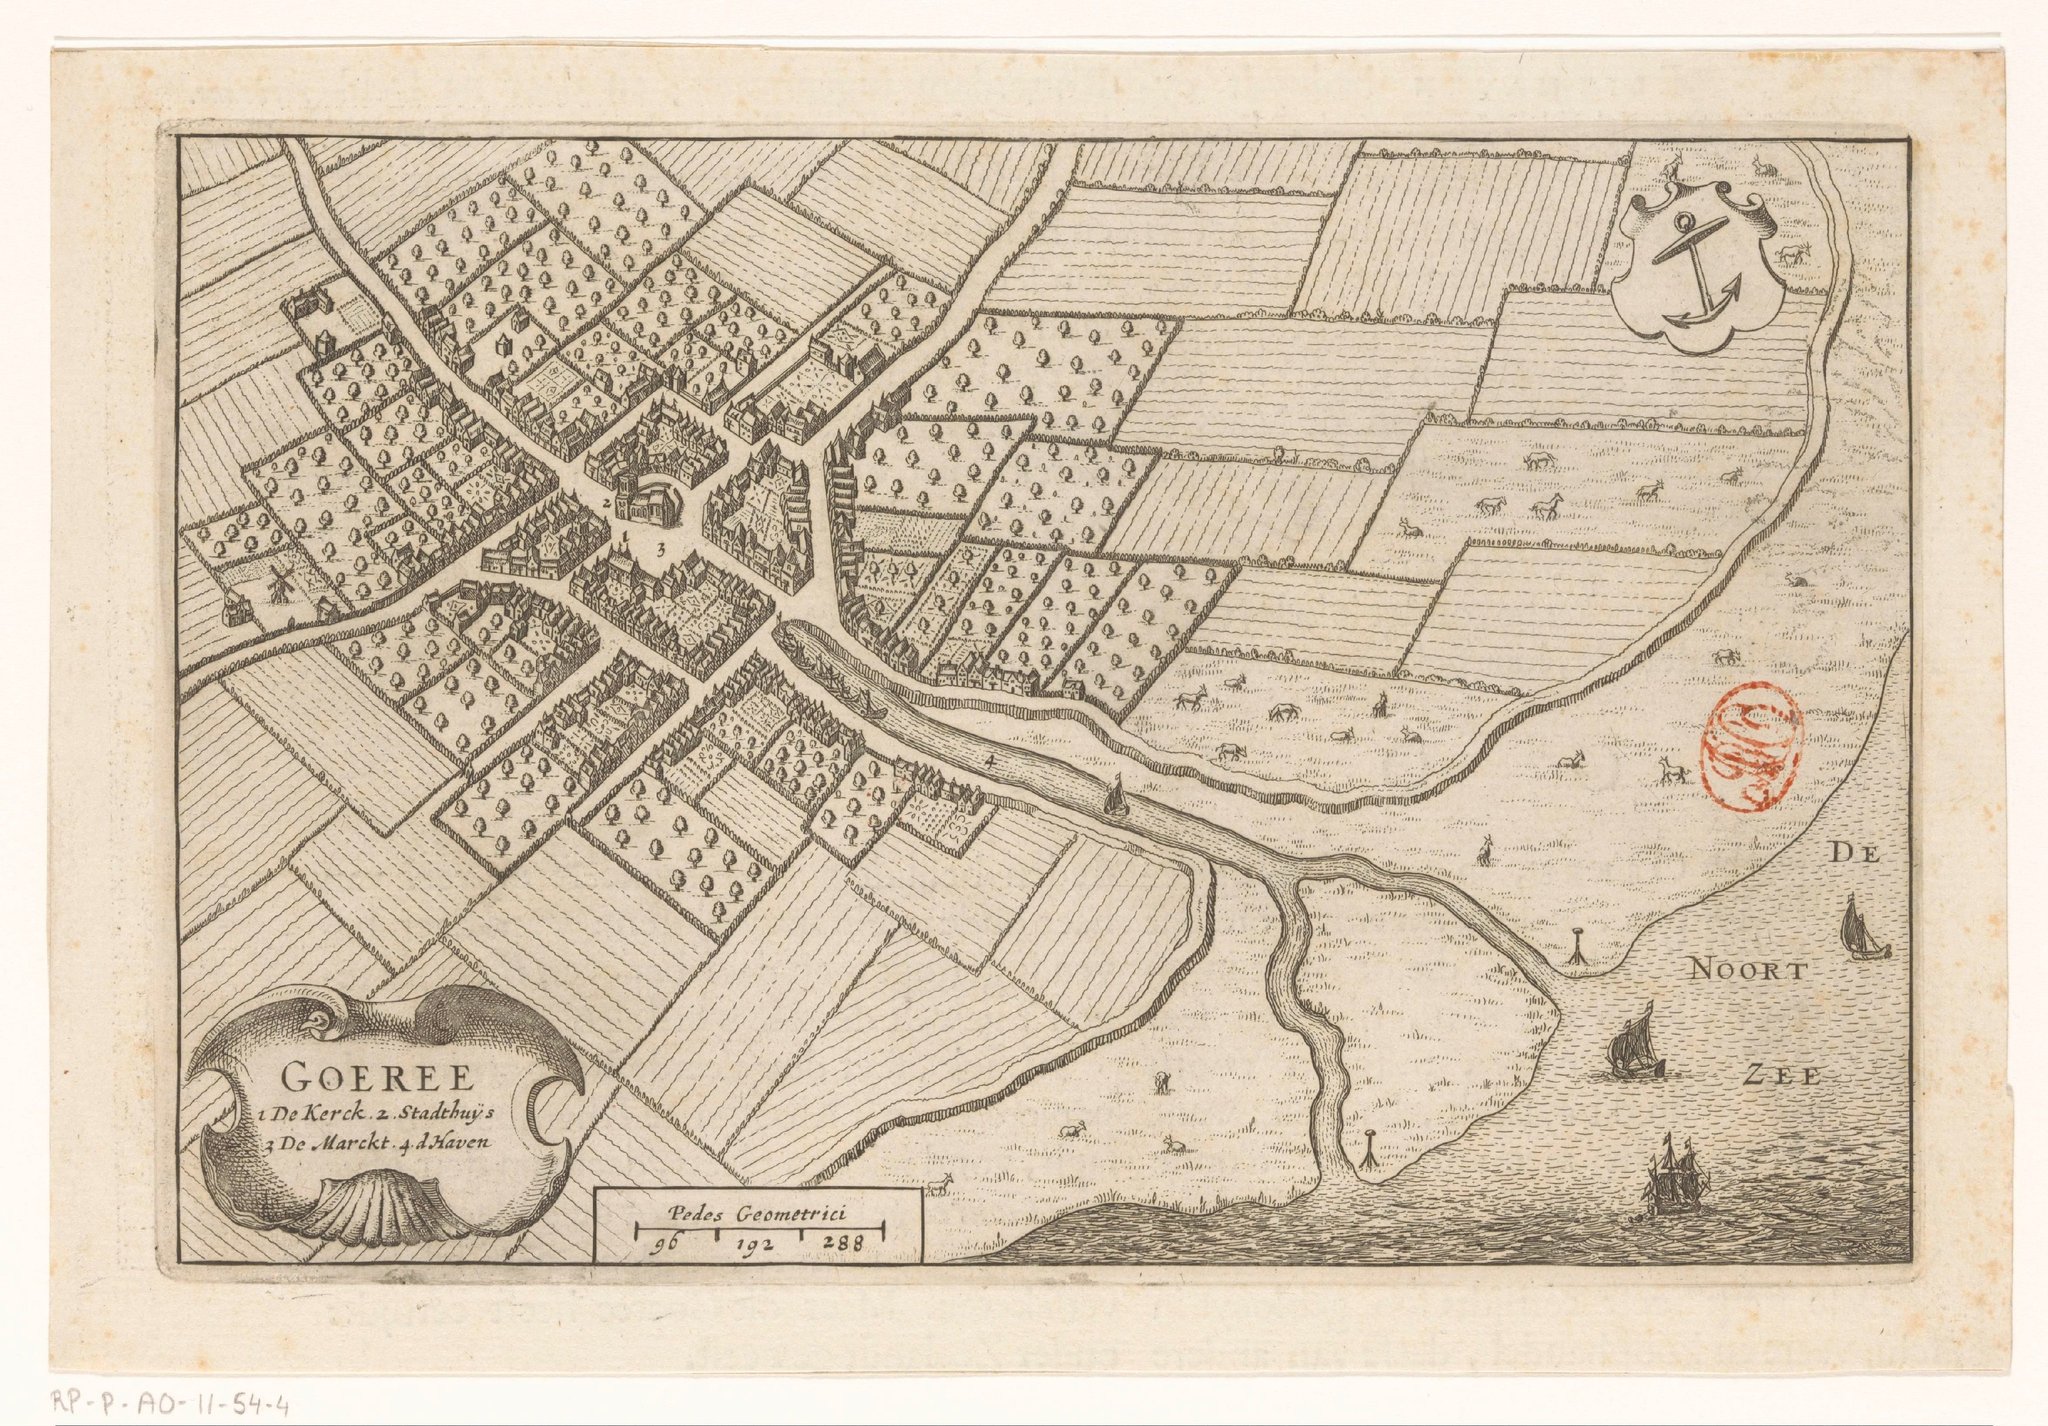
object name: print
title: Plattegrond van Goedereede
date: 1652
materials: paper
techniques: engraving, etching, letterpress printing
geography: amsterdam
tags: coat of arms (as symbol of the state, etc.) (+ city; municipal), maps of cities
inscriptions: collector's mark: Lugt 195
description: Prent gebruikt in: Blaeu, Johannes Willemszoon. Toonneel der steden van de Vereenighde Nederlanden. 2 delen. Amsterdam: Johannes Willemszoon Blaeu, 1652, dl. 1. Prent voor het eerst ook gebruikt in: Boxhorn, Marcus Zuerius van. Theatrum sive Hollandiae comitatus et urbium nova descriptio (…). Amsterdam: Henricus Hondius, 1632.